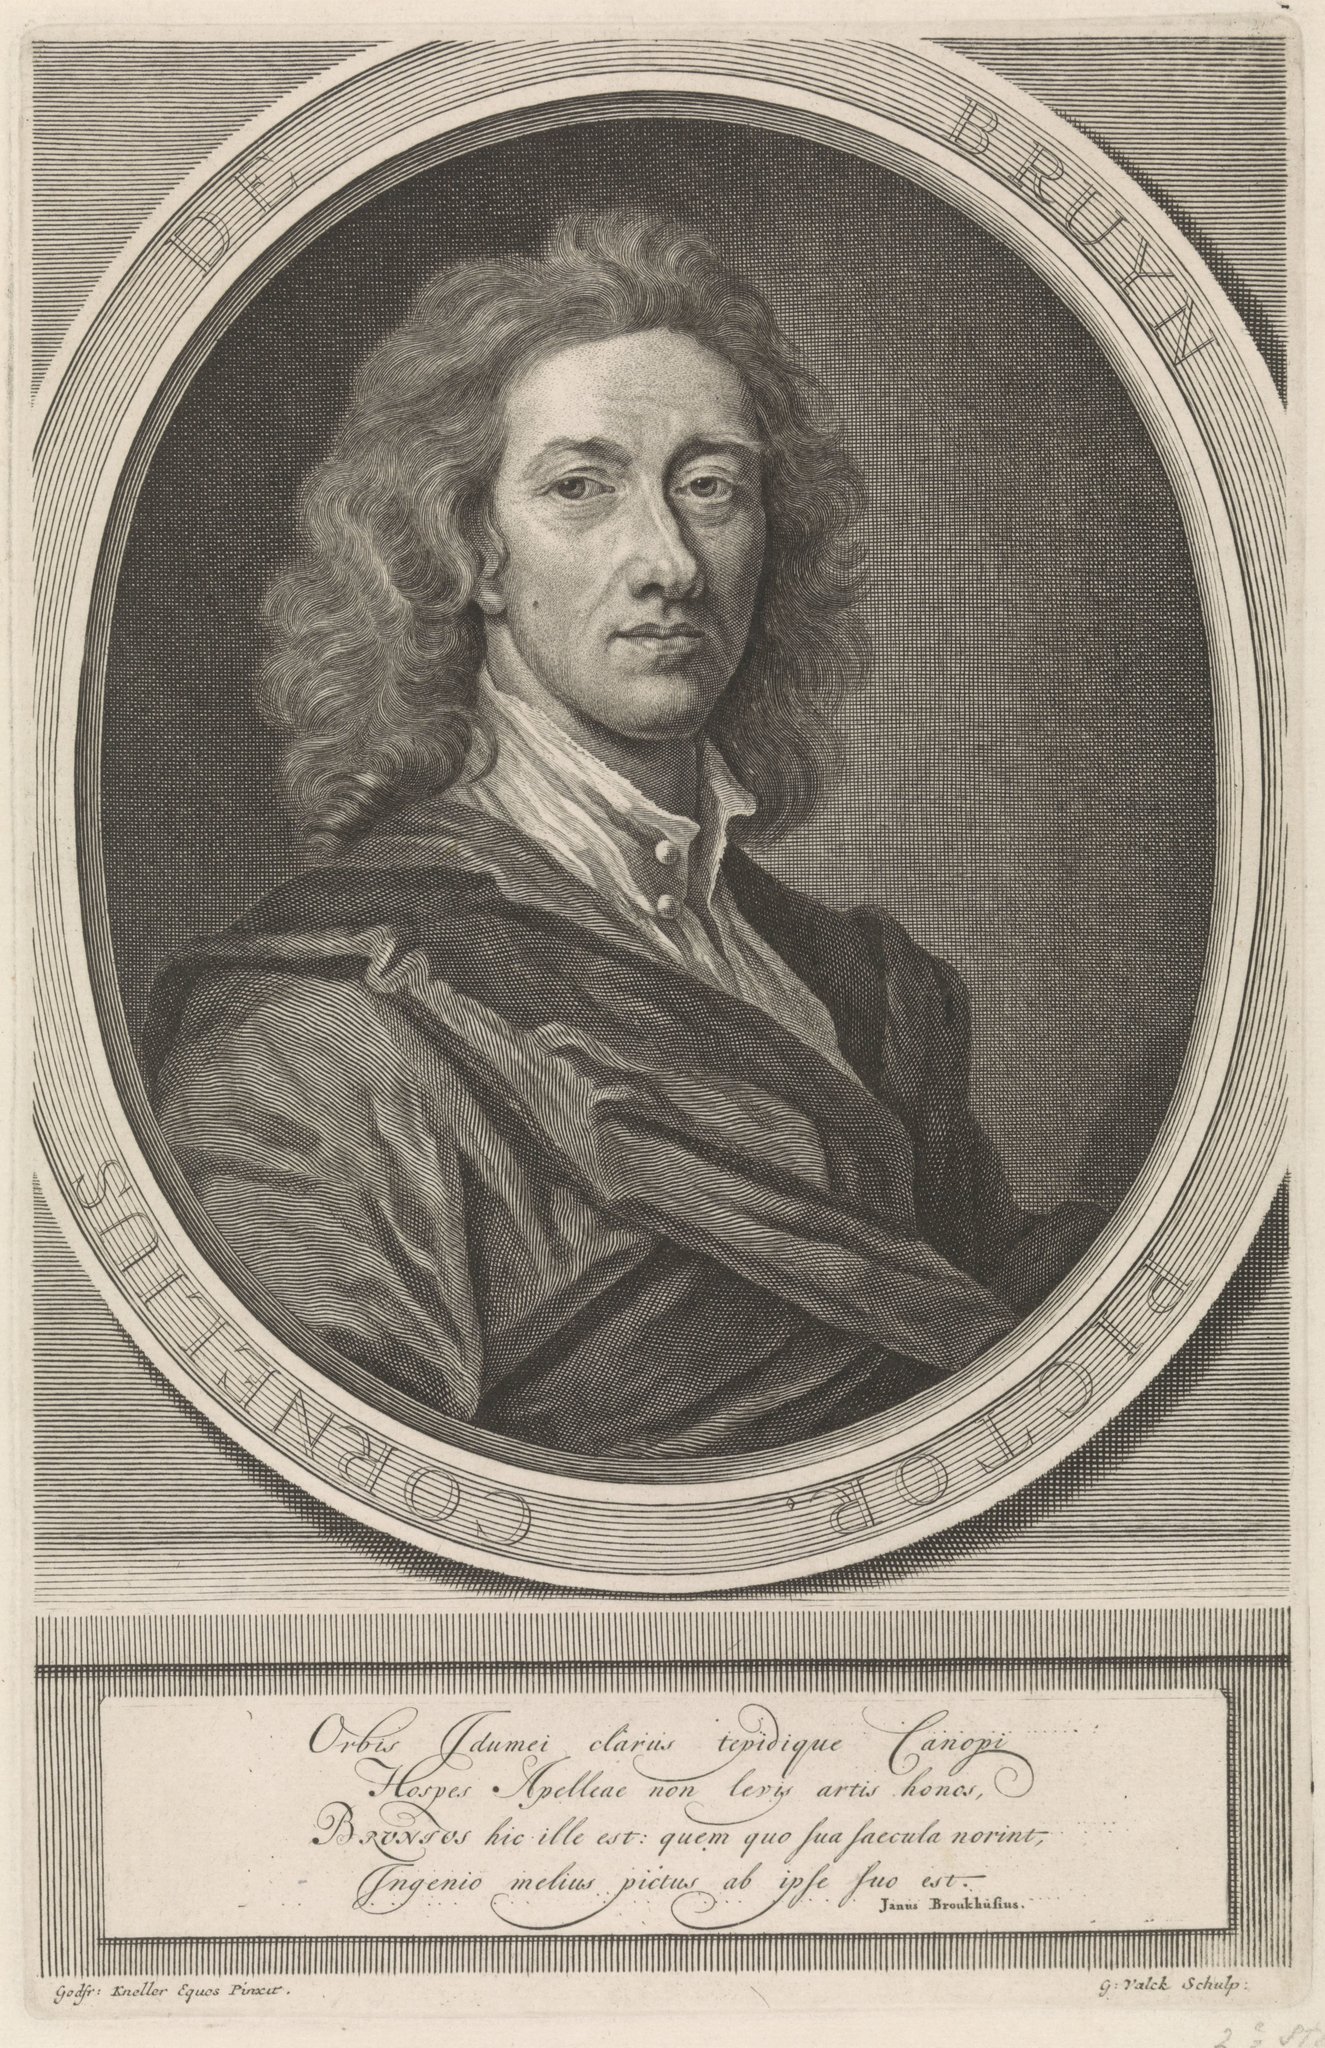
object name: print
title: Portret van de schilder Cornelis de Bruyn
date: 1698-1726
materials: paper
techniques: engraving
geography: amsterdam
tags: the hague, utrecht, draughtsman, cornelis de bruyn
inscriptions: collector's mark: Lugt 2228